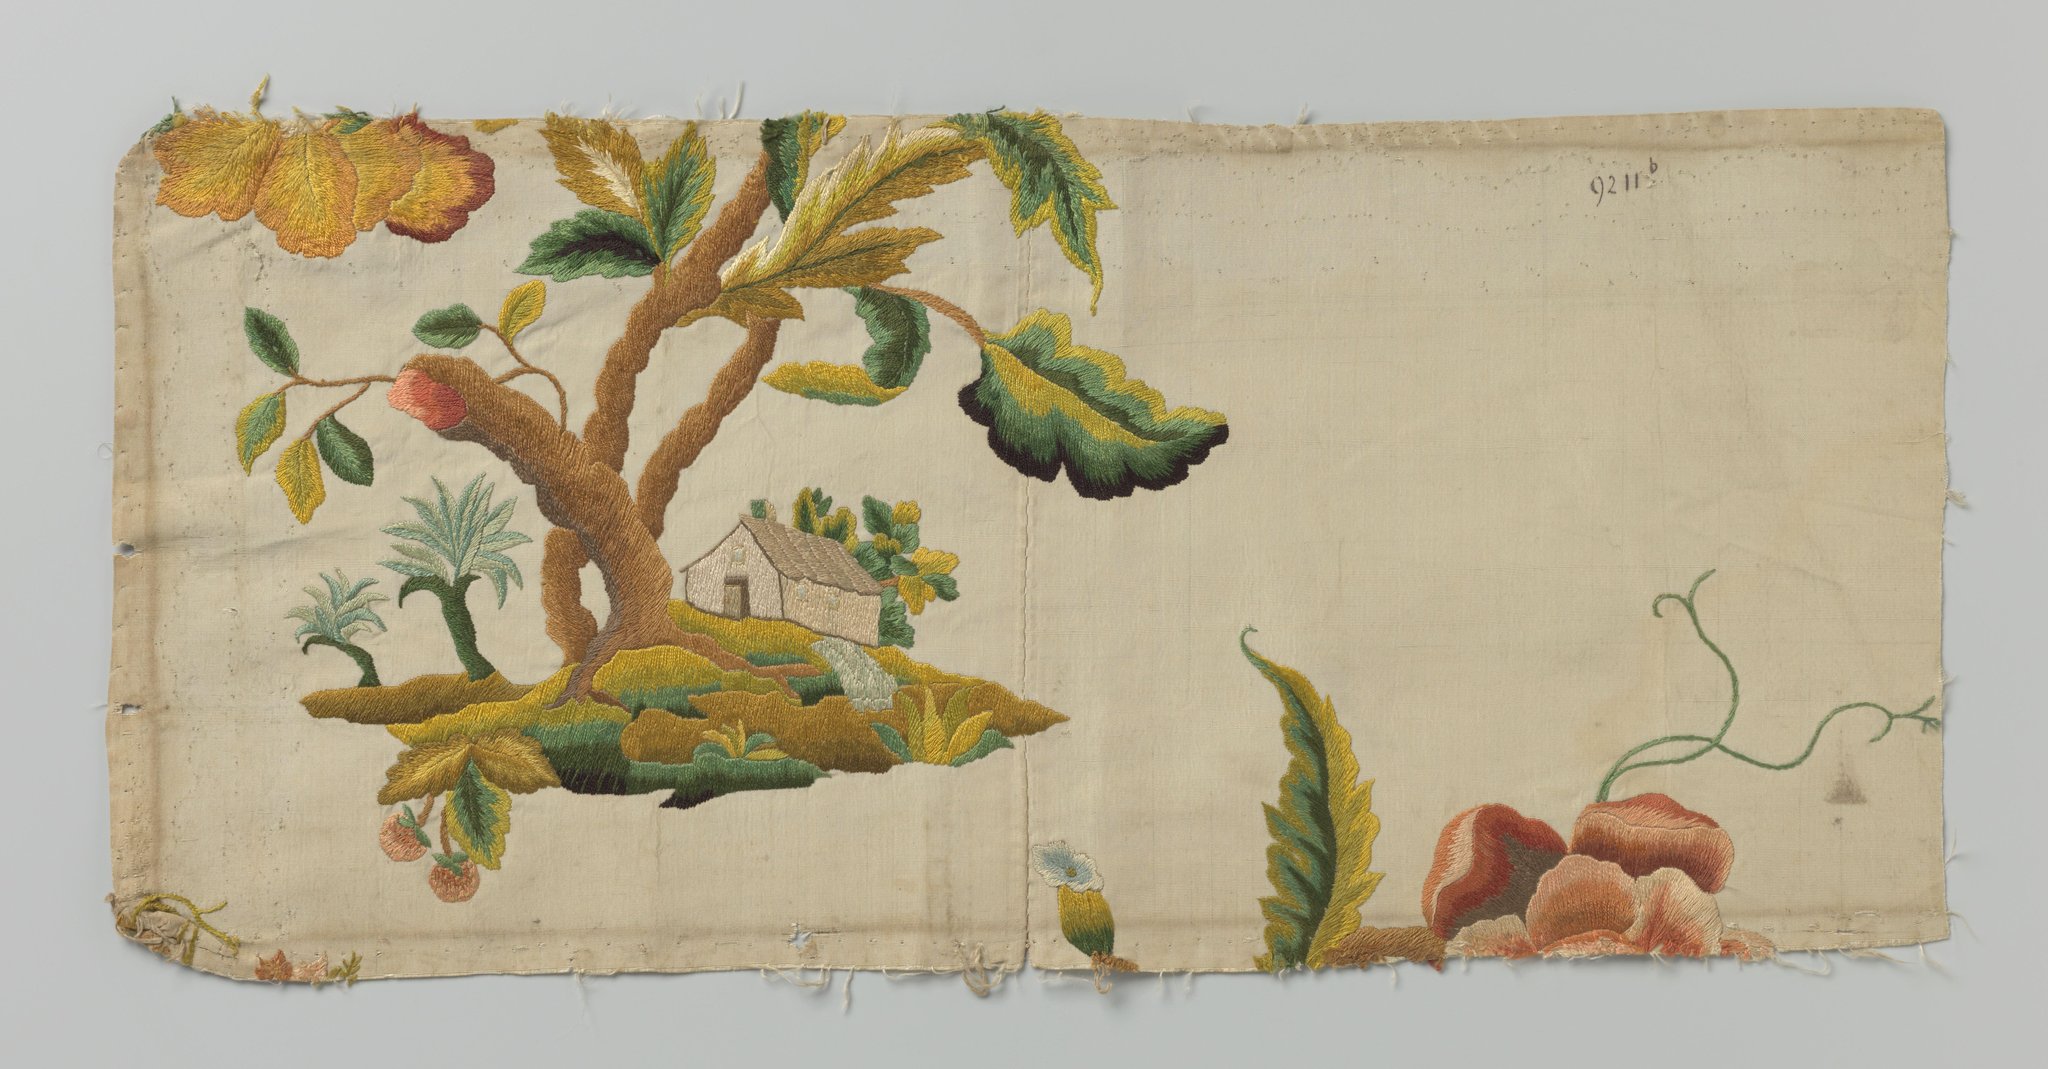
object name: lap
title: Lap van geborduurde zijde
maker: Anonymous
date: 1735-1740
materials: silk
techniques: embroidery stitch, woodworking, interlocking stitch, flat stitch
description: Twee aan elkaar gezette fragmenten van geborduurde witte zijde met een patroon van een huisje op een heuvel omringd door bomen en bloemen in roze, groen, blauw, wit en geel. Gerelateerd aan BK-NM-9202, BK-NM-9204 en BK-NM-9209.